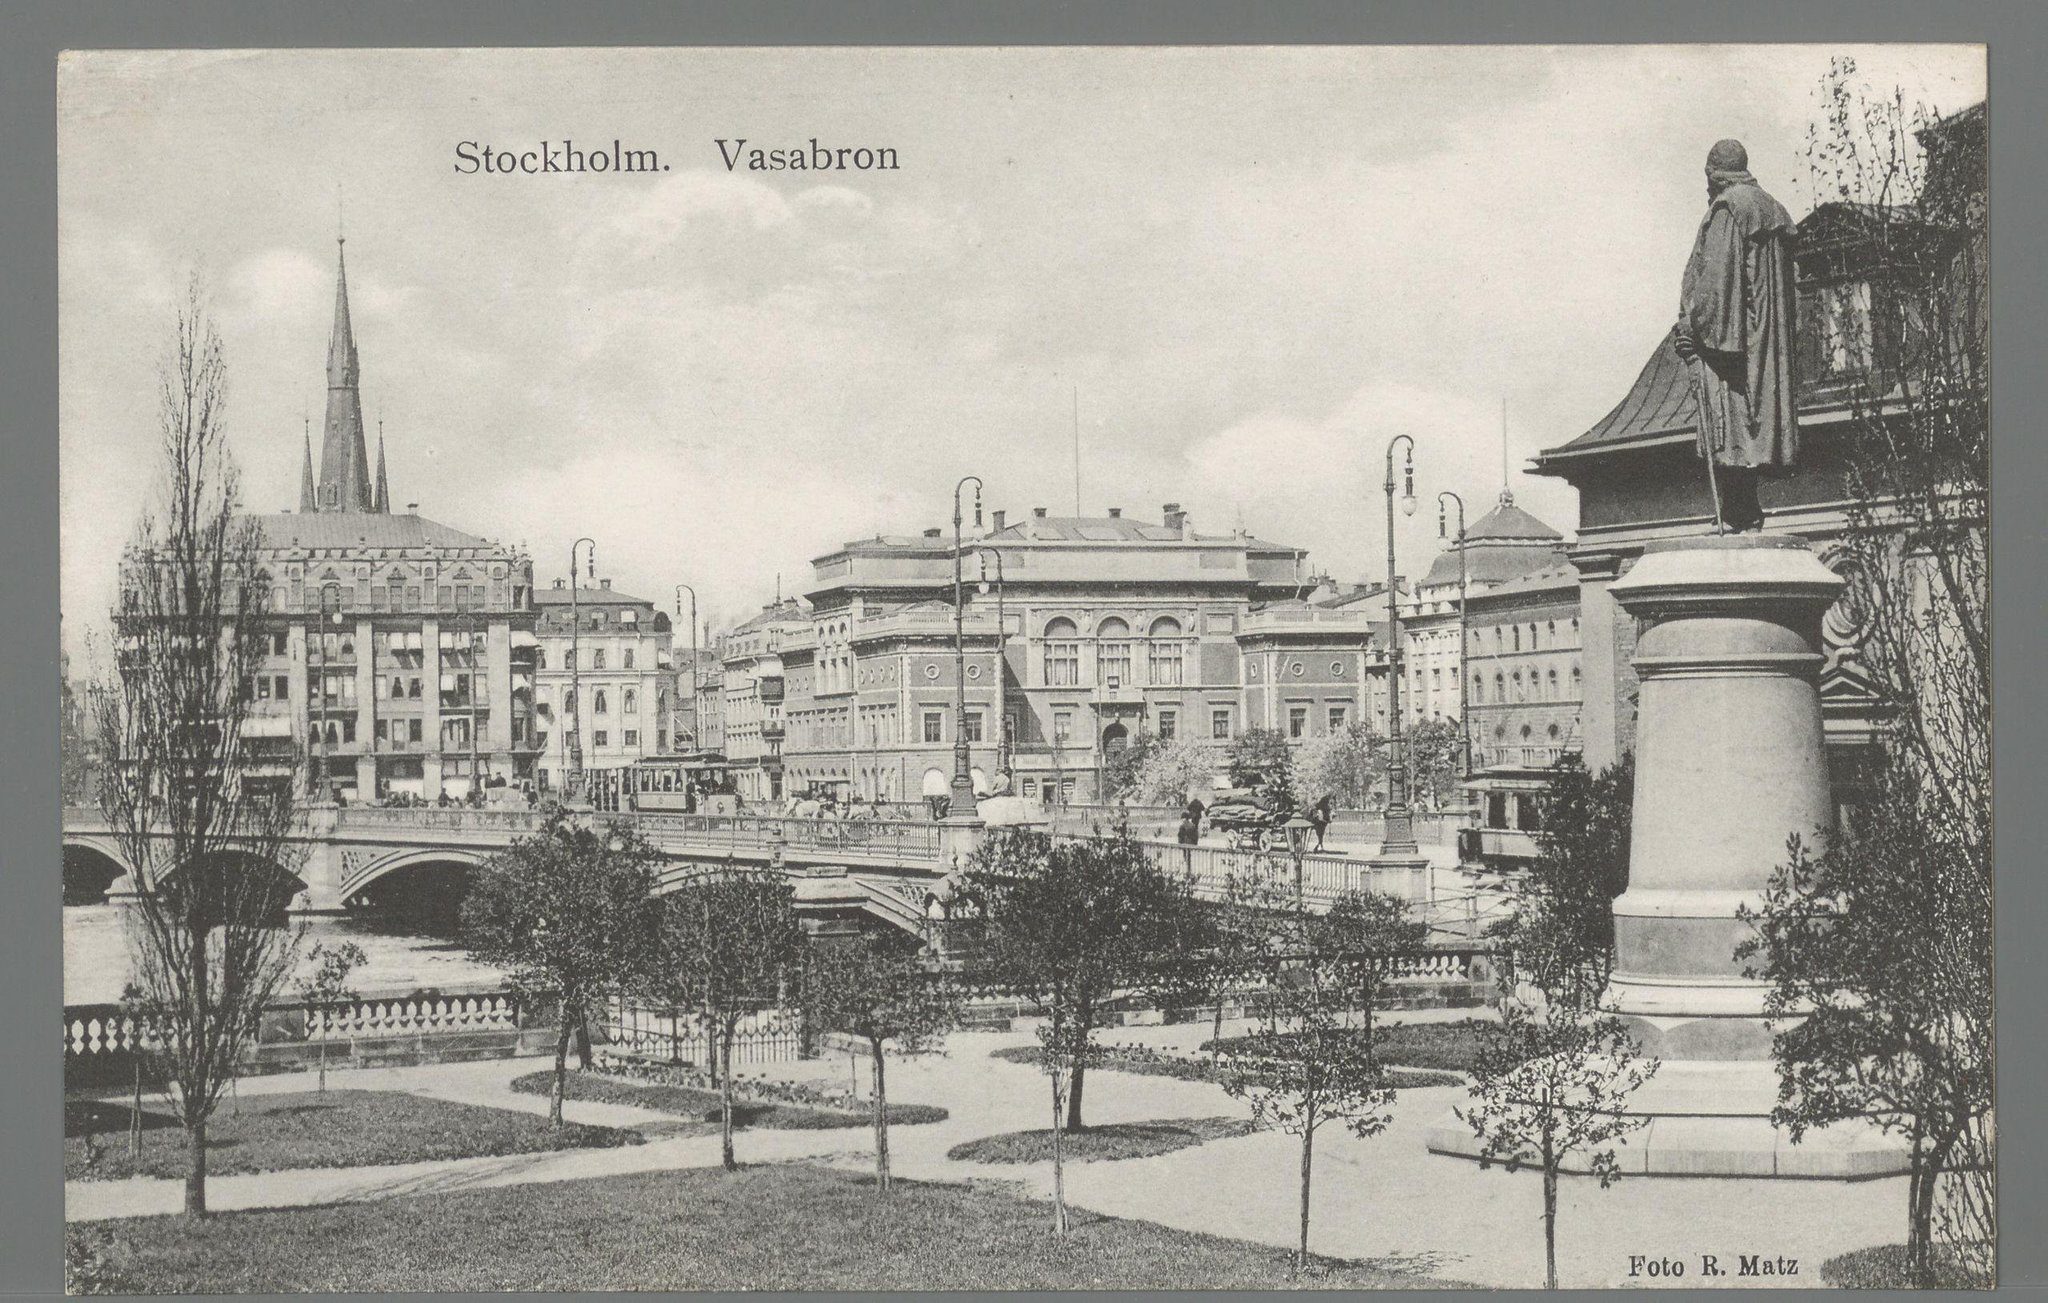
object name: ansichtkaart, prentbriefkaart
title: Stockholm. Vasabron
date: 1905-1930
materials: cardboard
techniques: photograph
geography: stockholm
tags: monument, statue, bridge in city across river, canal, etc.